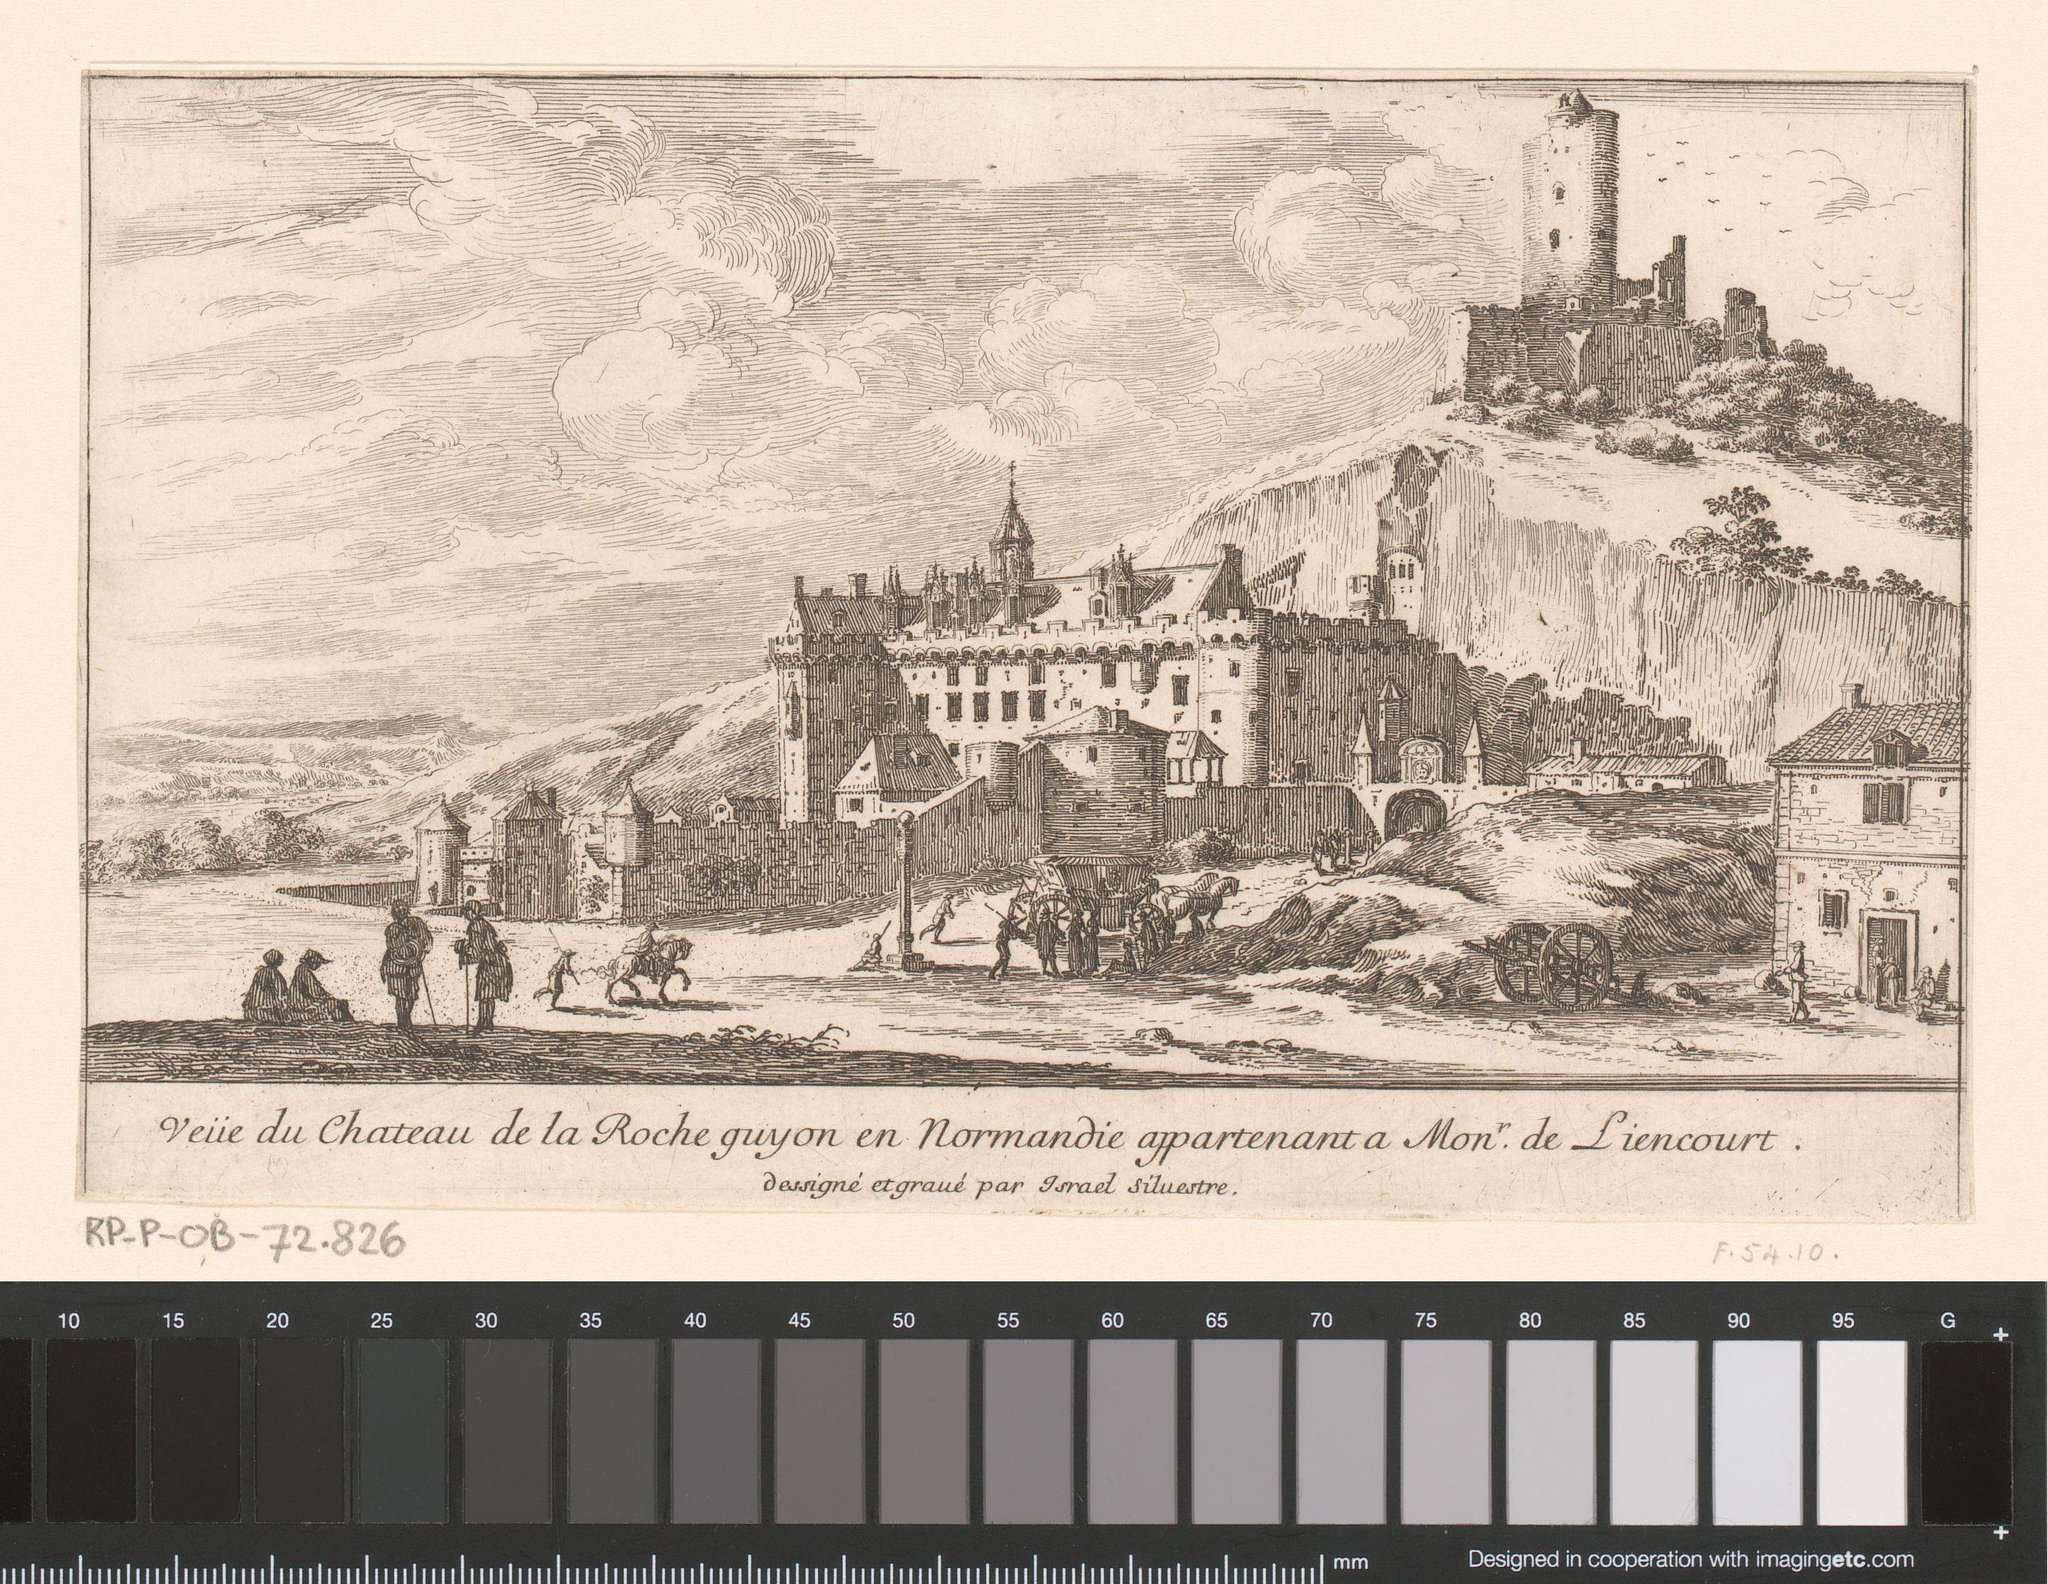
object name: print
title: Diverses Veües faites sur le Naturel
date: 1658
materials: paper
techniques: etching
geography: france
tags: landscape with tower or castle (+ city(-scape) with figures, staffage)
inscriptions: collector's mark: Lugt 240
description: Prent maakt deel uit van een ongenummerde serie van tien prenten.